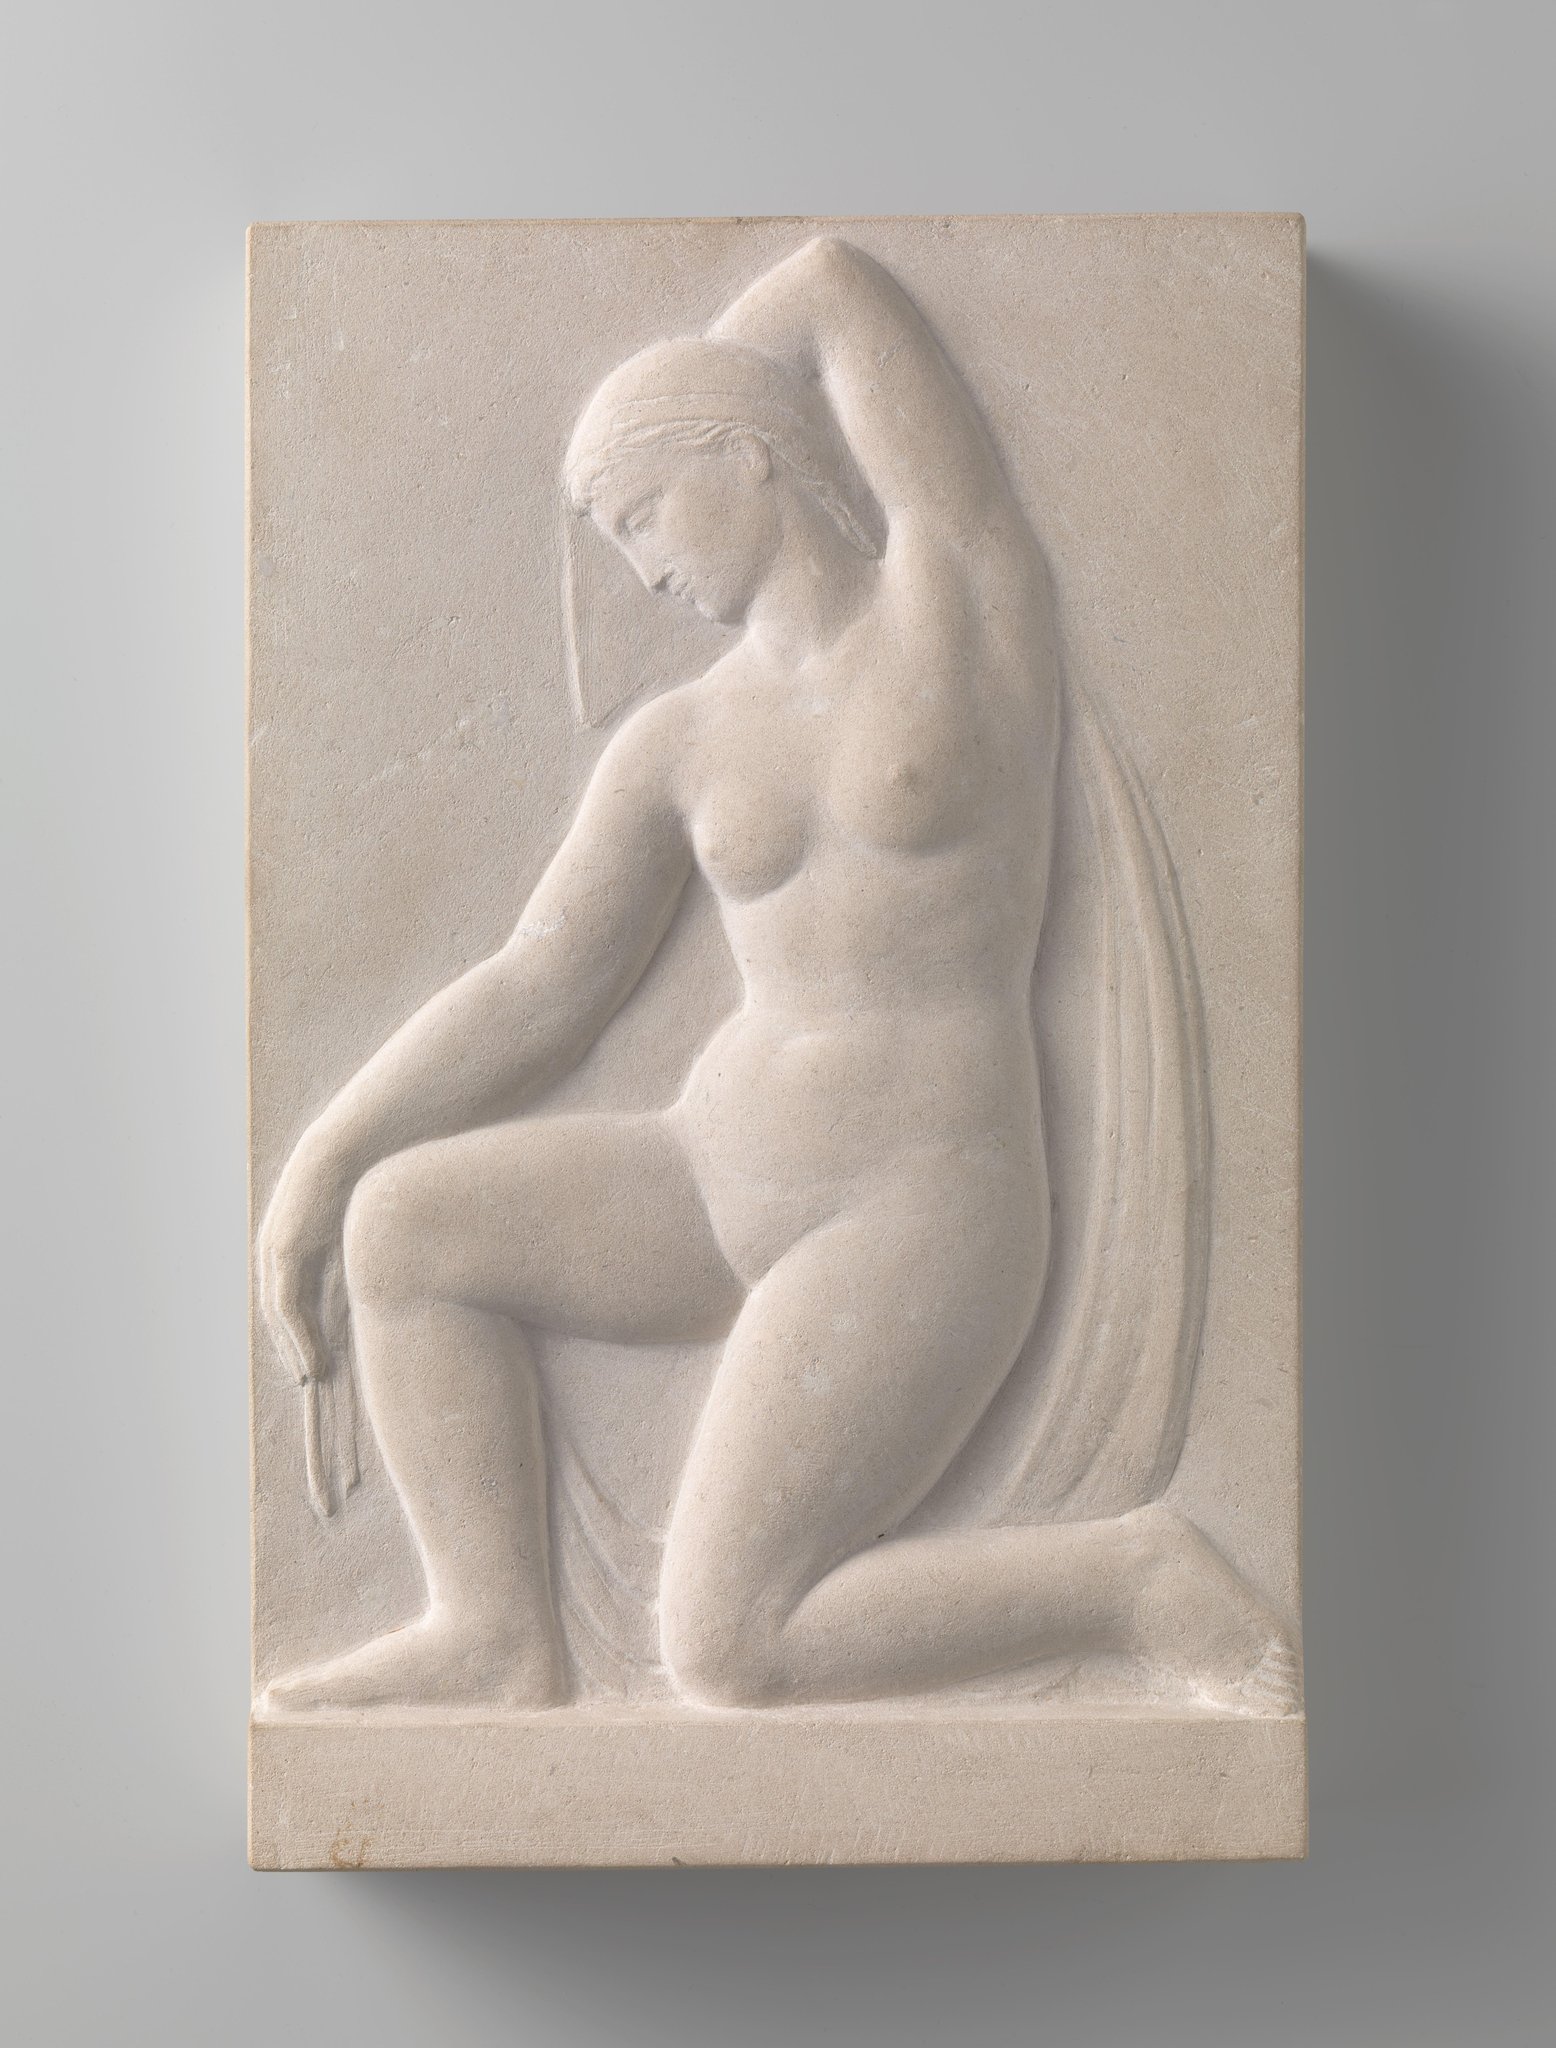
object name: sculpture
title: Reliëf met een naar links geknielde, naakte vrouw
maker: hans reicher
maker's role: sculptor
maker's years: 1895-1963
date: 1939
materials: stone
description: Reliëf van steen met naar links geknielde naakte vrouw.